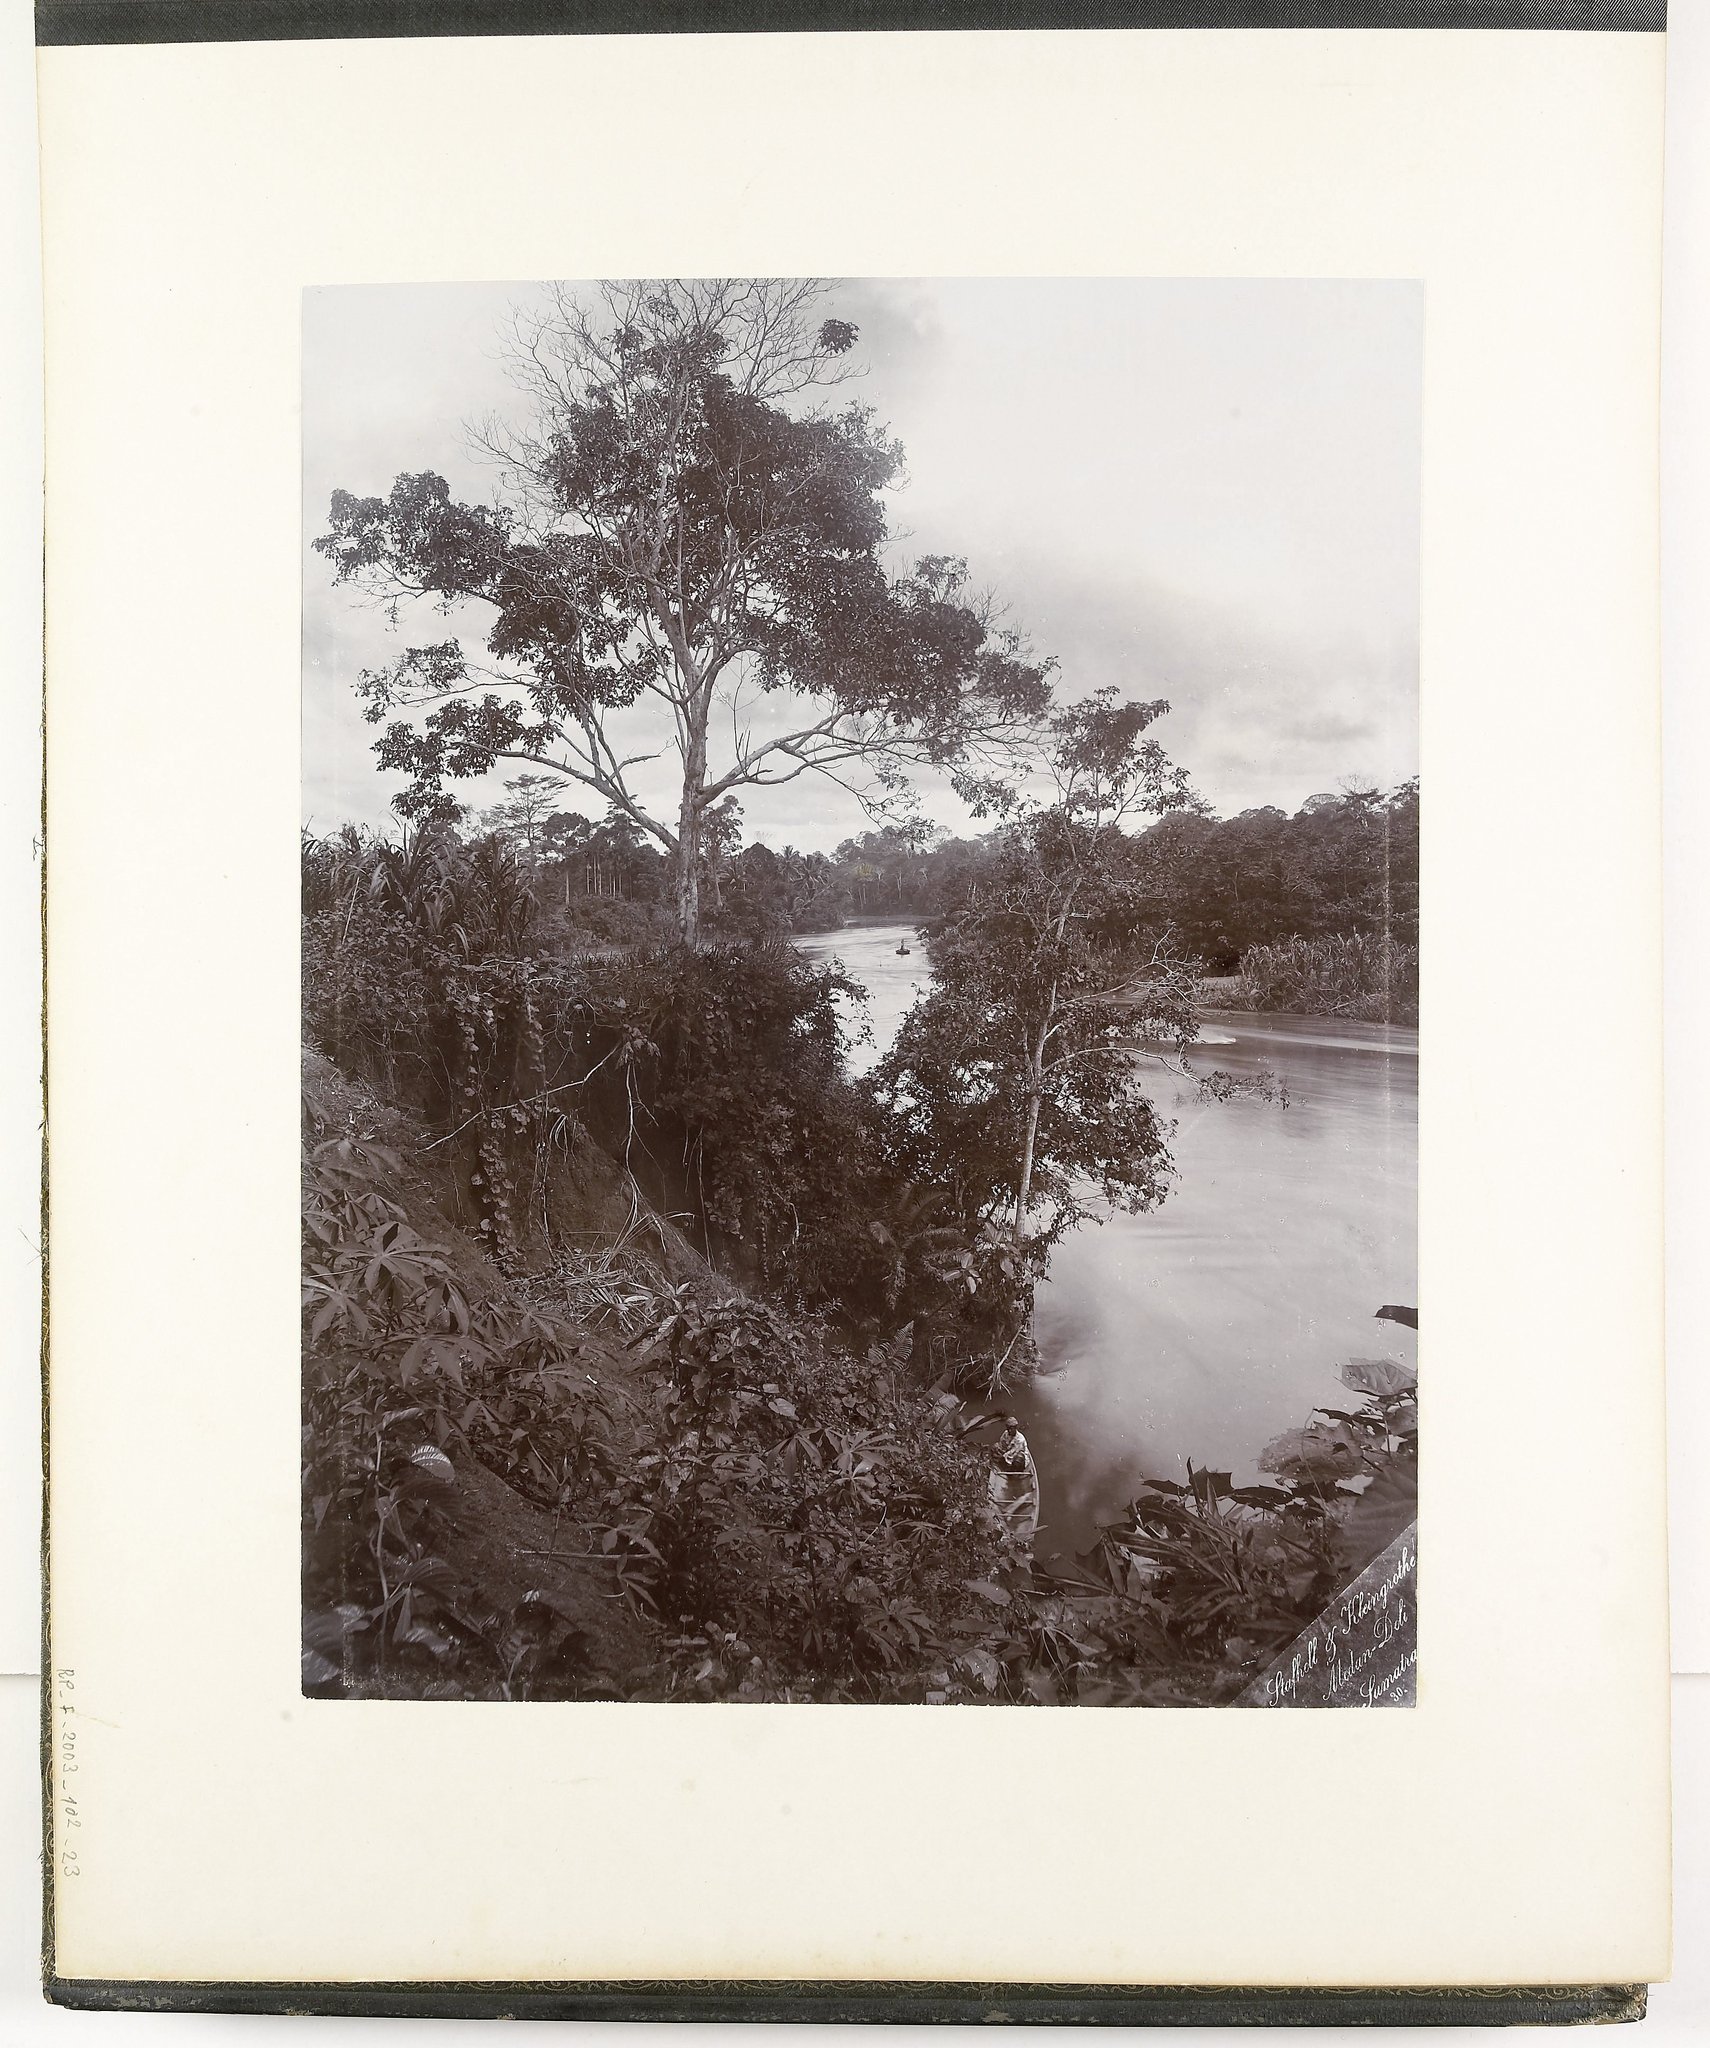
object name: photograph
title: Gezicht langs de oever van de rivier de Wampoe, Sumatra (Wampoe Fluss)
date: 1890-1900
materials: photographic support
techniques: collodion silver print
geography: medan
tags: sumatra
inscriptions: number: ‘Sumatra 30.’, signature: ‘Stafhell & Kleingrothe Medan-Deli’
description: Benedenloop van de Wampu (Wampoe) rivier. Langs de kant een bootje met een man. Onderdeel van het Sumatra fotoalbum van Paul en Lucie Sandel uit 1900.